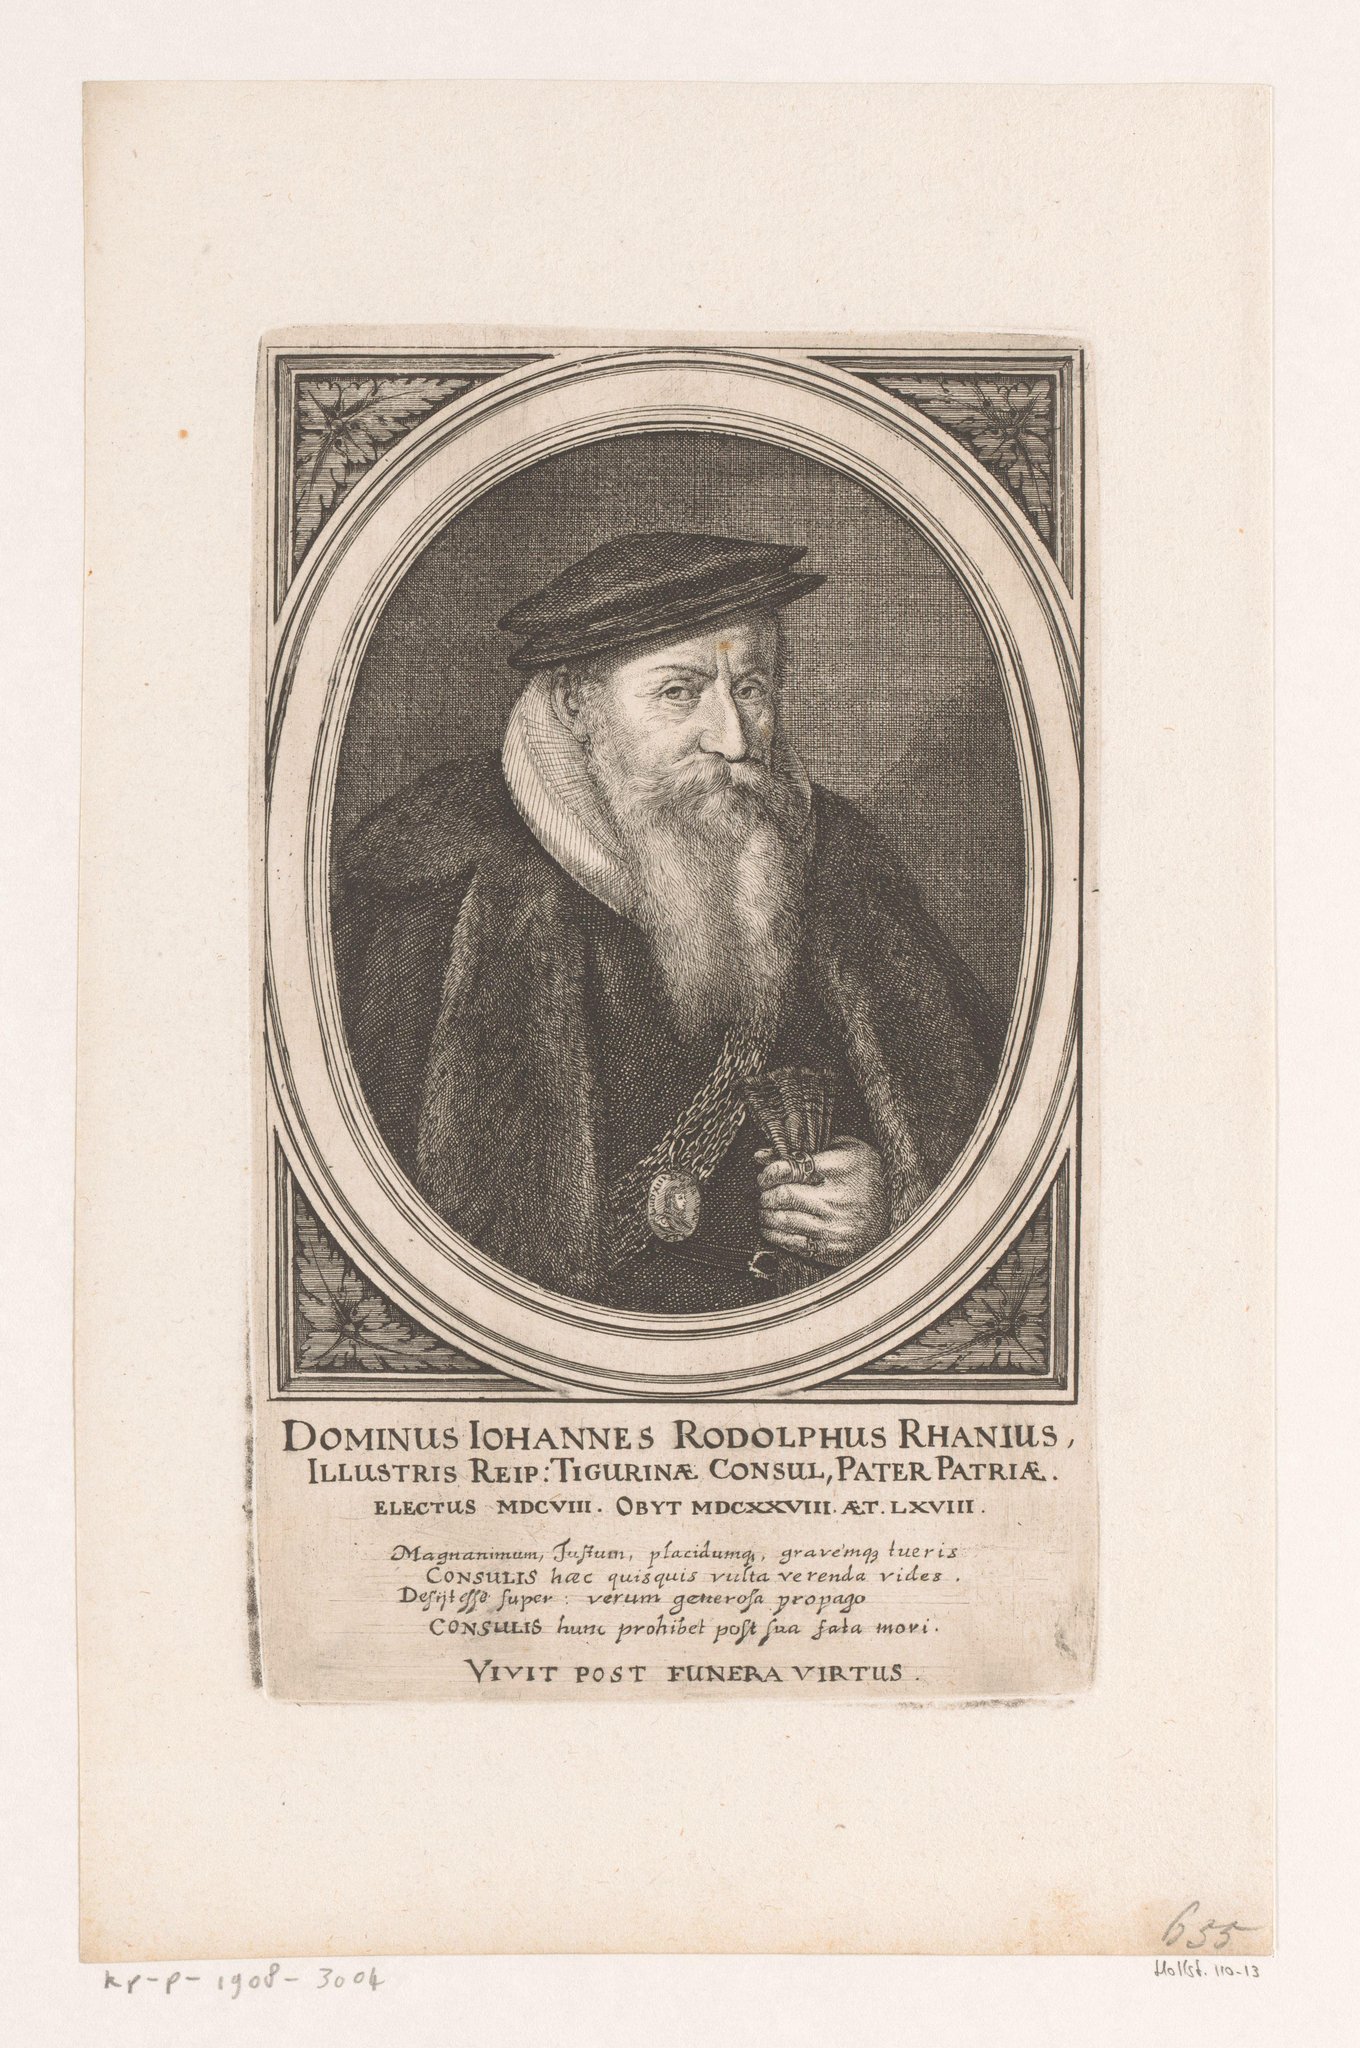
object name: print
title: Portret van Johann Rudolf Rahn (I)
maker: conrad meyer (i)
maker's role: painter, print maker, publisher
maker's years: 1618-1689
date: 1628-1689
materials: paper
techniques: engraving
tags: mayor, mayor, burgomaster, gloves, mittens, etc., other non-personal regalia, e.g. mayor chain, historical persons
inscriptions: collector's mark: Lugt 2228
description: Onderdeel van een serie van 67(?) portretten van burgemeesters van Zürich. Zie Hollstein German 110, 1-26.